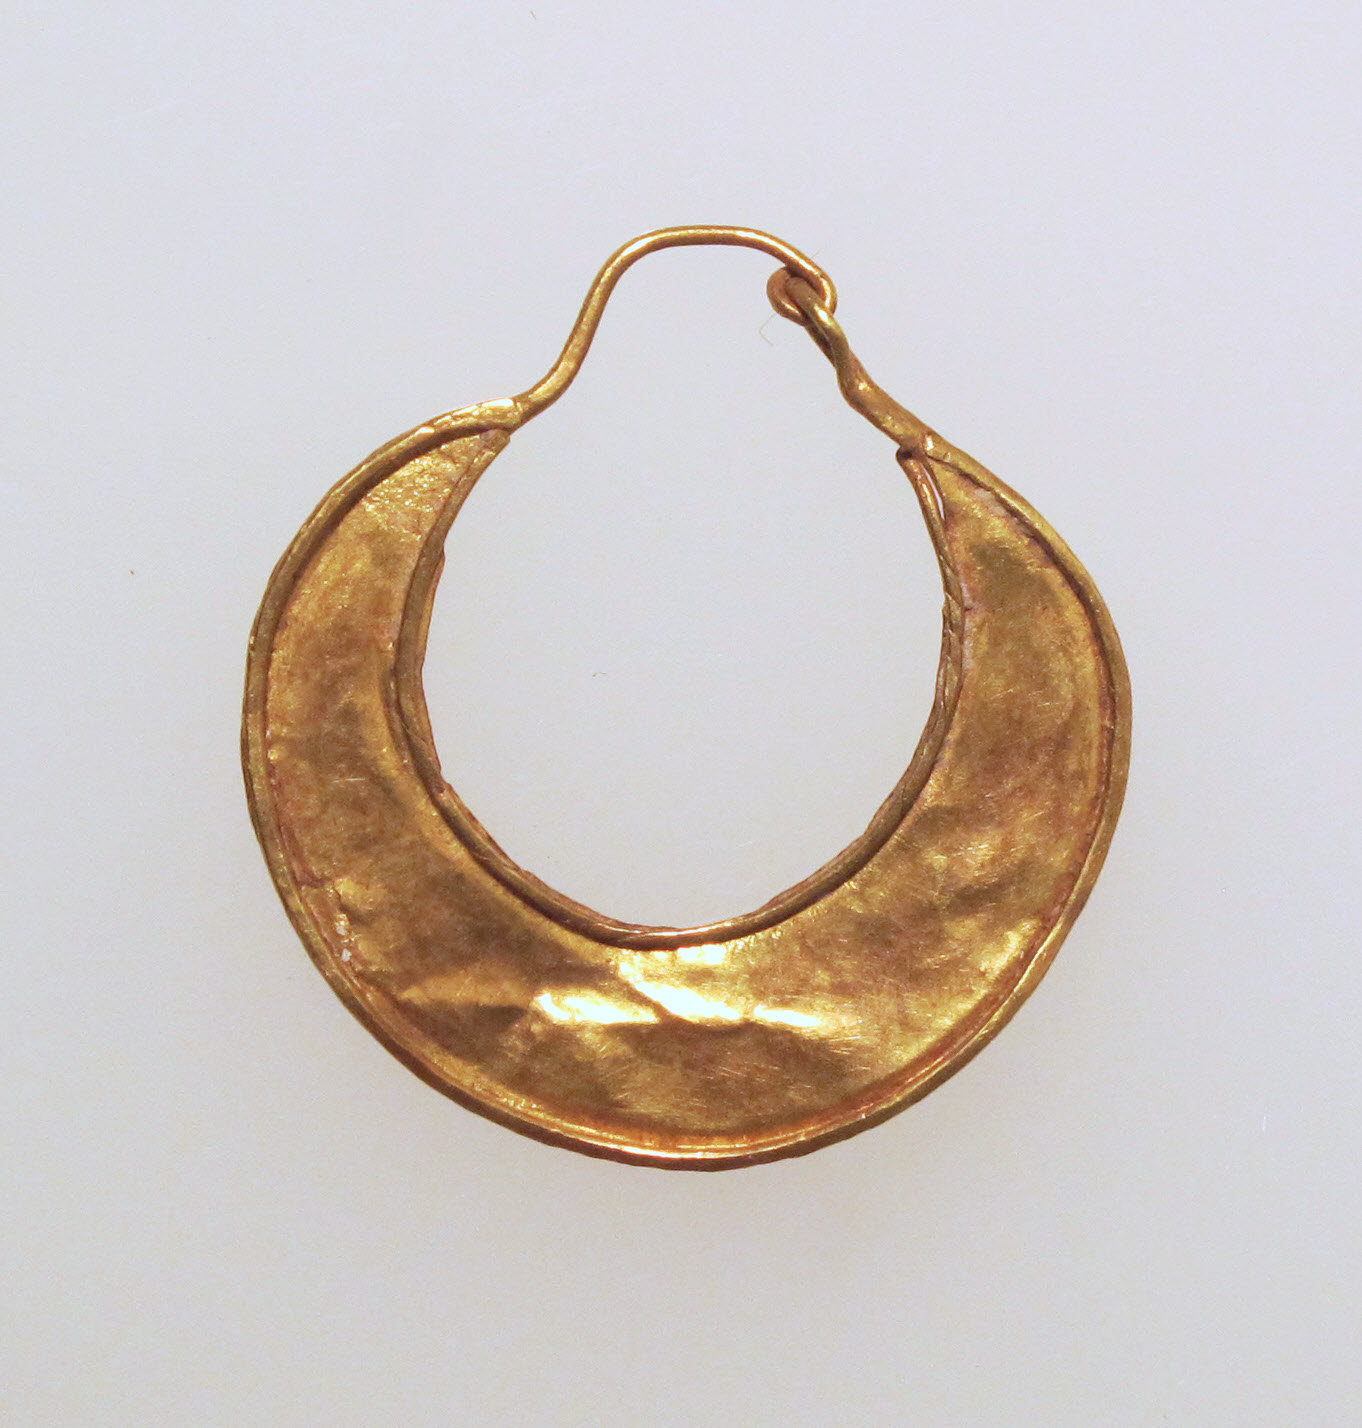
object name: earring, crescent shaped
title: Earring, crescent-shaped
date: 7000 BCE-330 CE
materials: gold